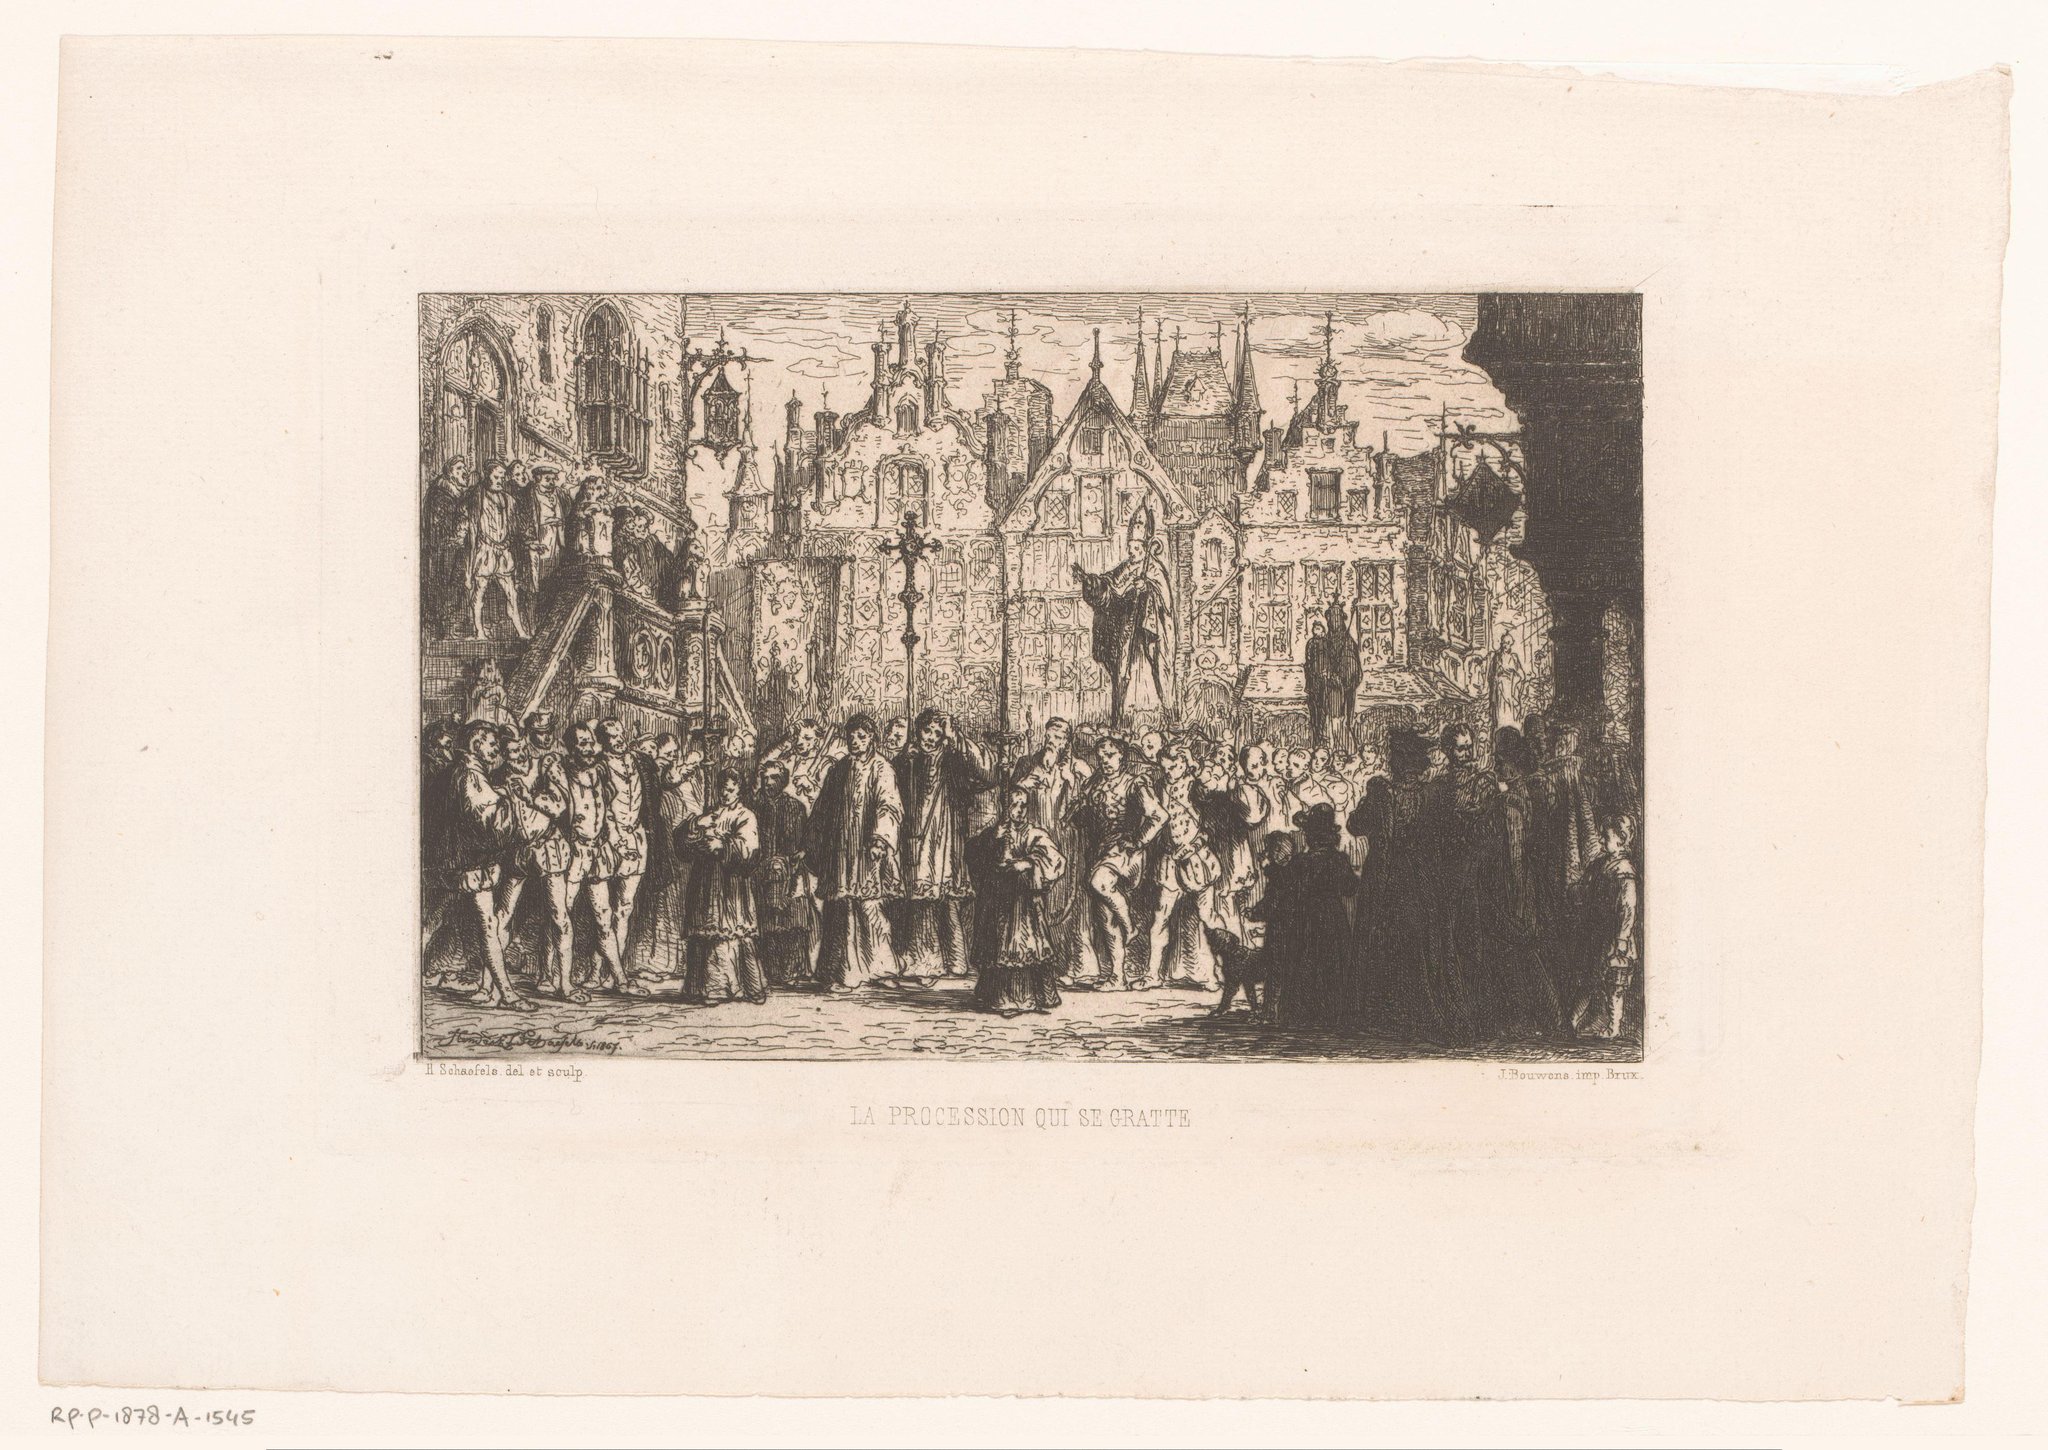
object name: print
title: Mensen krabben zichzelf tijdens een processie door de stad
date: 1867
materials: paper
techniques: etching, intaglio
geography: brussels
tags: square, place, circus, etc., scratching one's head, procession ~ christian religion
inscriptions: collector's mark: Lugt 2228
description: Prent uit: Coster, Charles de. La légende et les aventures héroiques, joyeuses et glorieuses d'Ulenspiegel et de Lamme Goedzak au pays de Flandres et ailleurs. Parijs: Librairie Internationale, 1869.